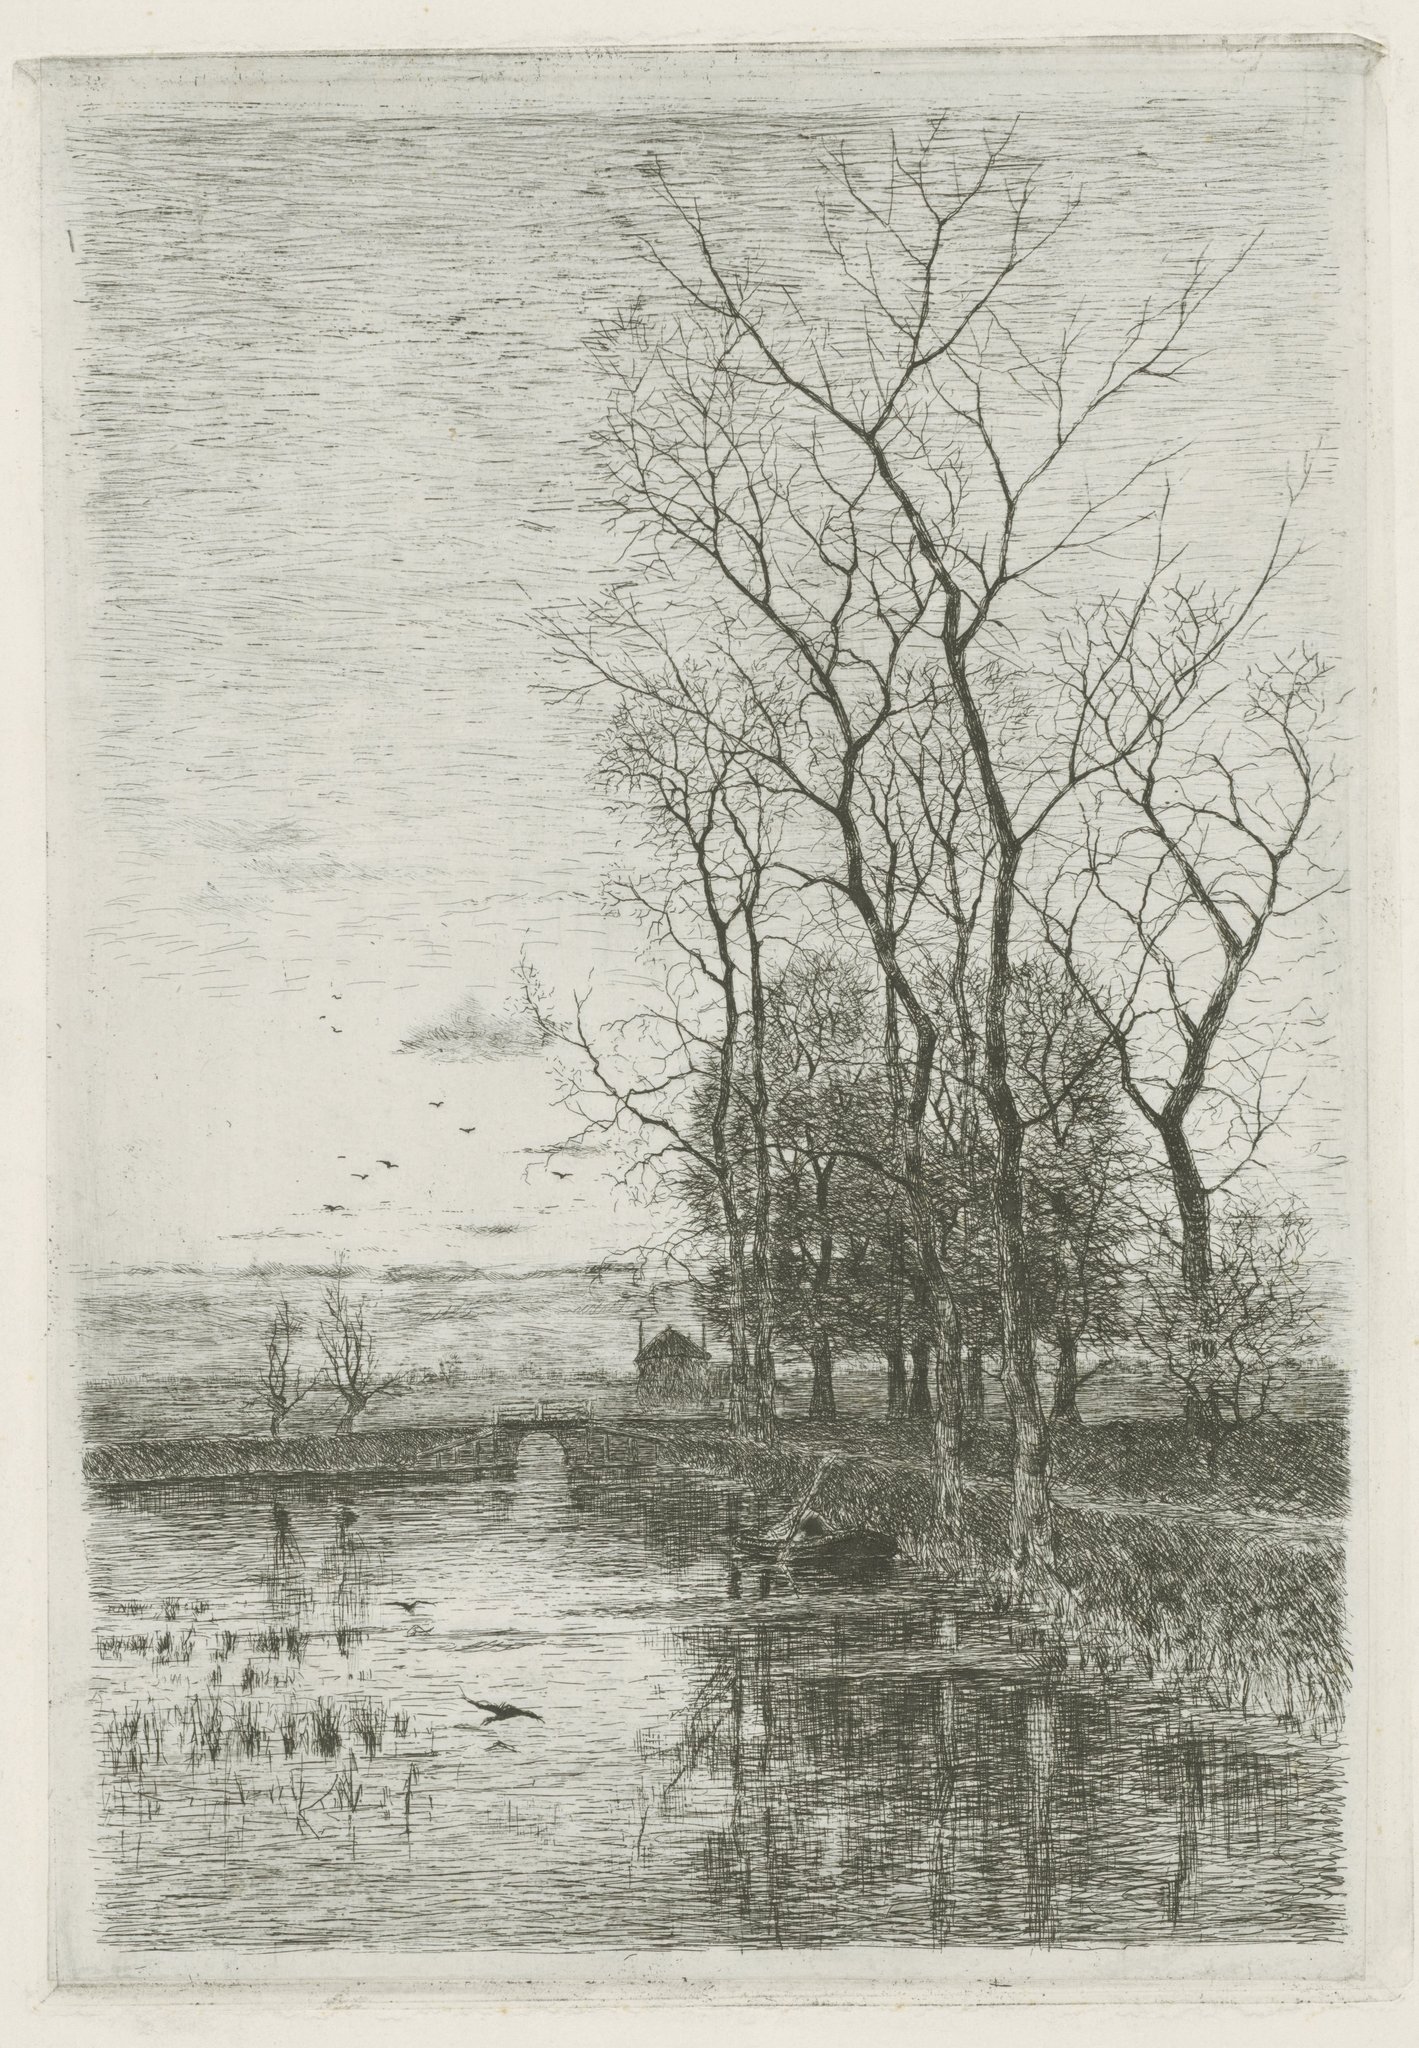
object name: print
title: De kleine brug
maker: fredericus jacobus van rossum du chattel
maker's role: draughtsman, painter, print maker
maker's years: 1856-1917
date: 1873-1892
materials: paper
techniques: drypoint, etching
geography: netherlands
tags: landscapes with waters, waterscapes, seascapes (in the temperate zone)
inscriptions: collector's mark: Monogram van Paul van den Velden, collector's mark: Lugt 2228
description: Waterlandschap met een kleine brug bij een dijk met knotwilgen en andere bomen.